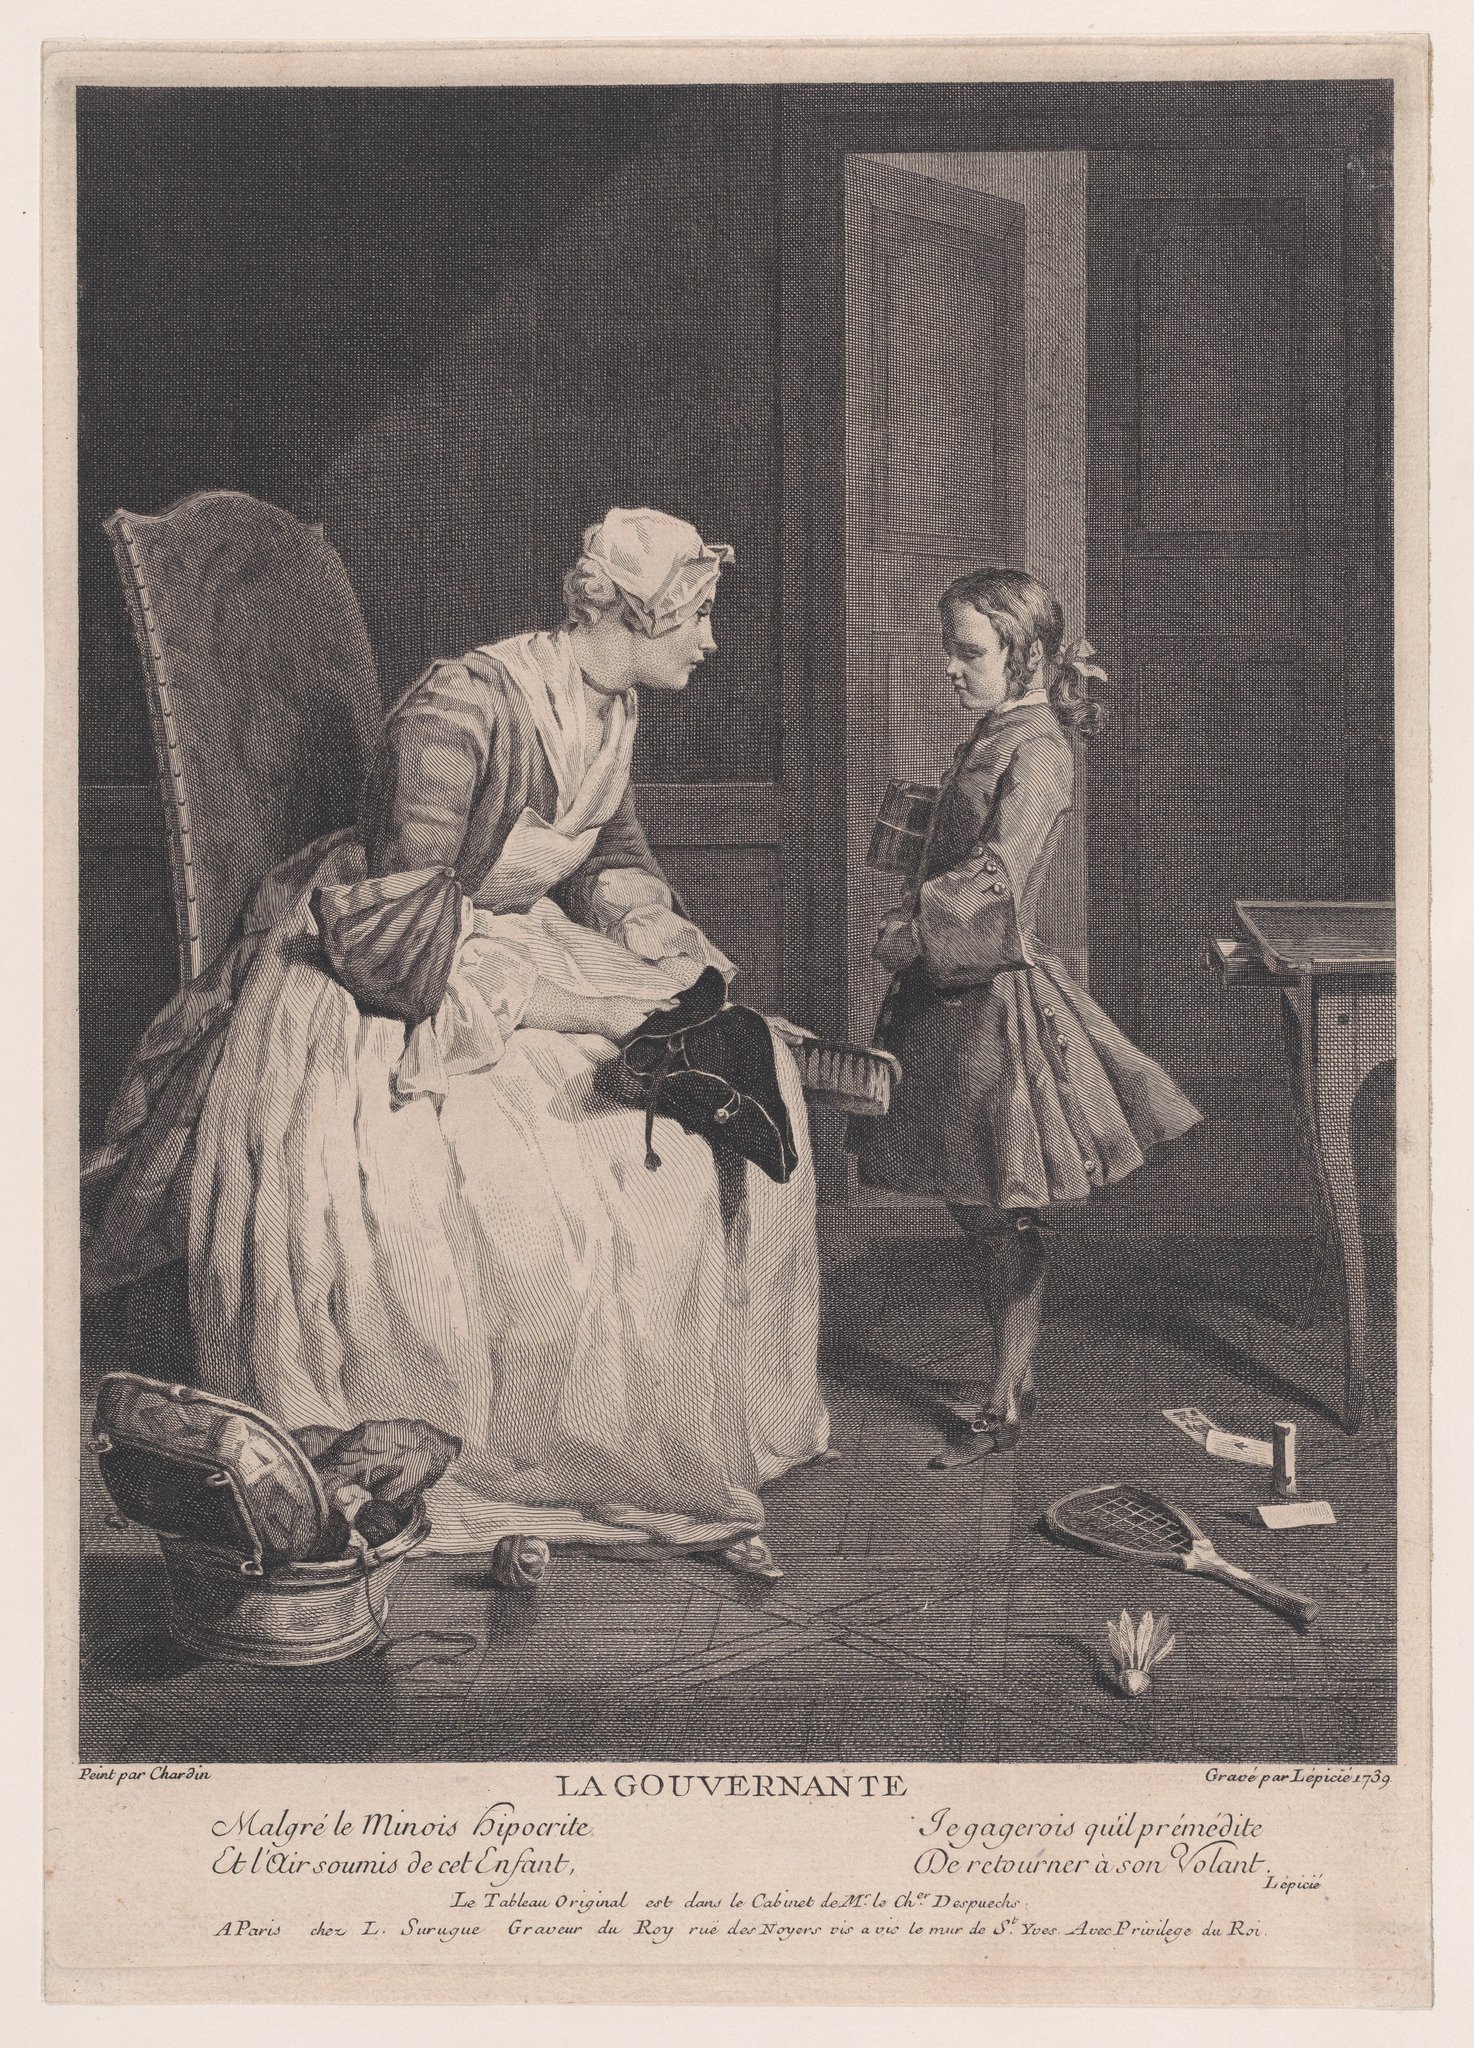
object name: print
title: The Governess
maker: bernard lepicié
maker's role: artist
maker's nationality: french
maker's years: 1698-1755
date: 1739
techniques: engraving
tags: hats,boys,women,toys